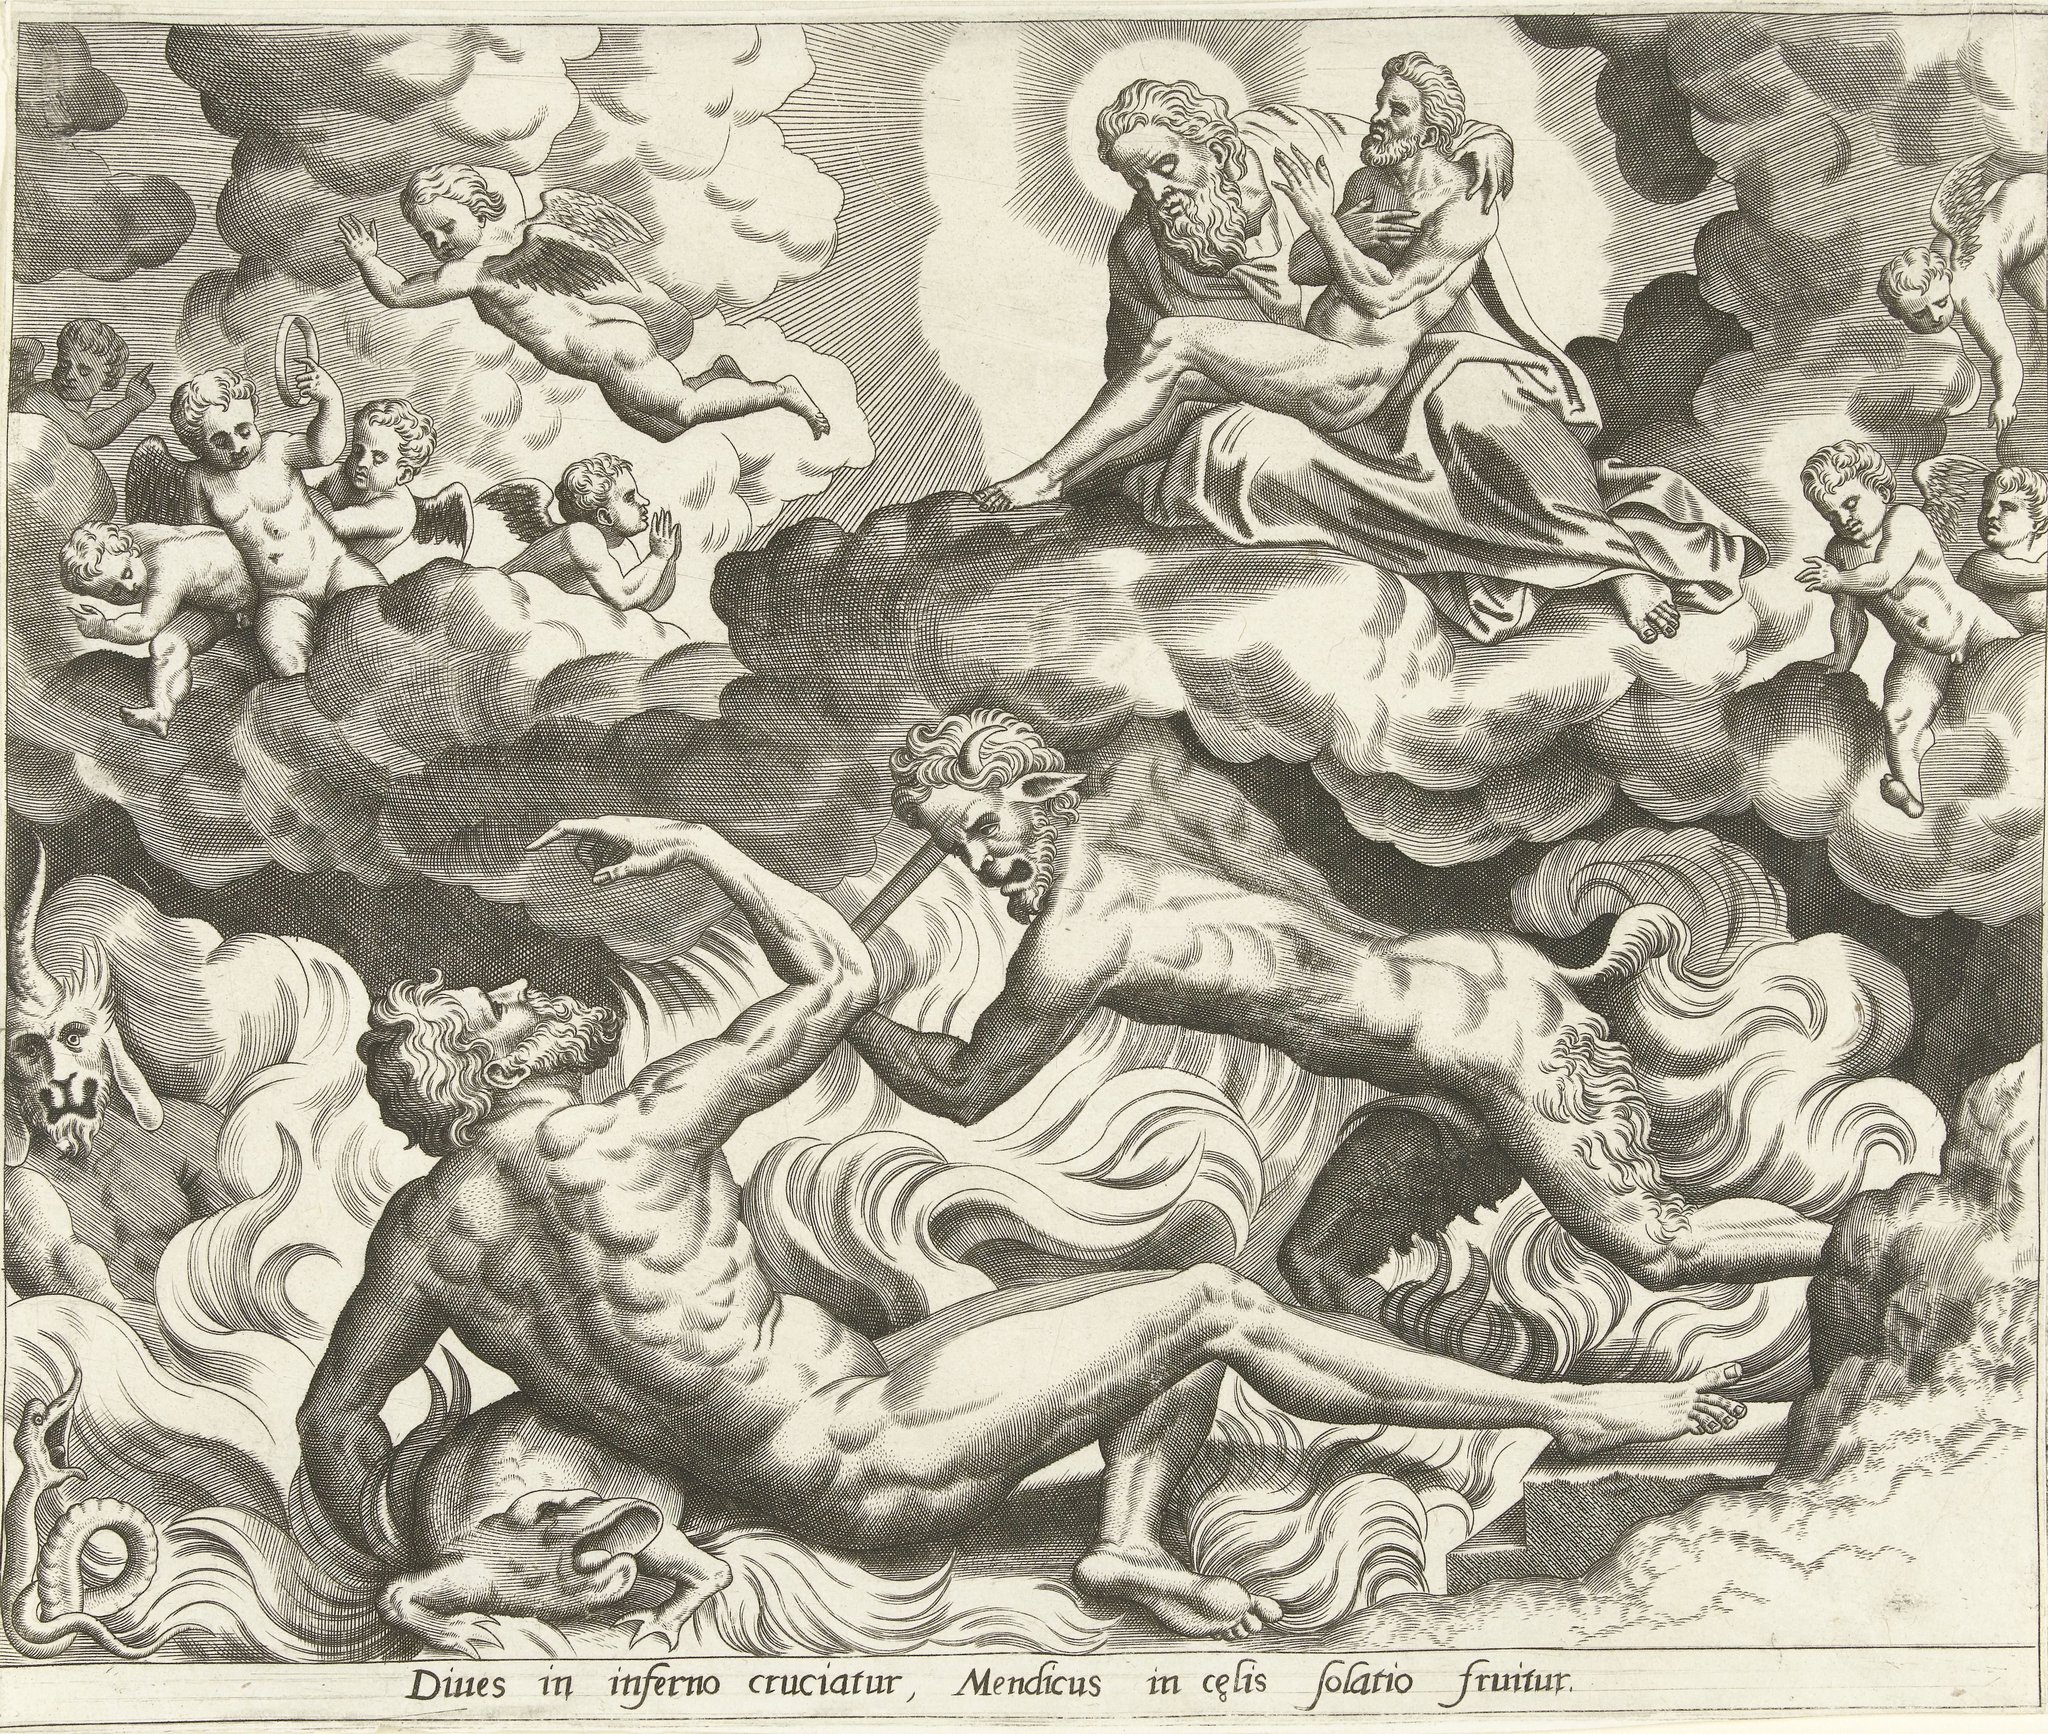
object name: print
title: De geschiedenis van Lazarus en de rijke man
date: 1560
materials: paper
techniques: engraving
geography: antwerp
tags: in hell dives sees lazarus in paradise; usually dives pointing at his tongue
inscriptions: collector's mark: Lugt 2760, watermark: Briquet 9652, collector's mark: Lugt 2228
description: De rijke man smoort in de hel en wordt door de duivel bedreigt. Hij ziet Lazarus in de hemel op Gods schoot zitten.